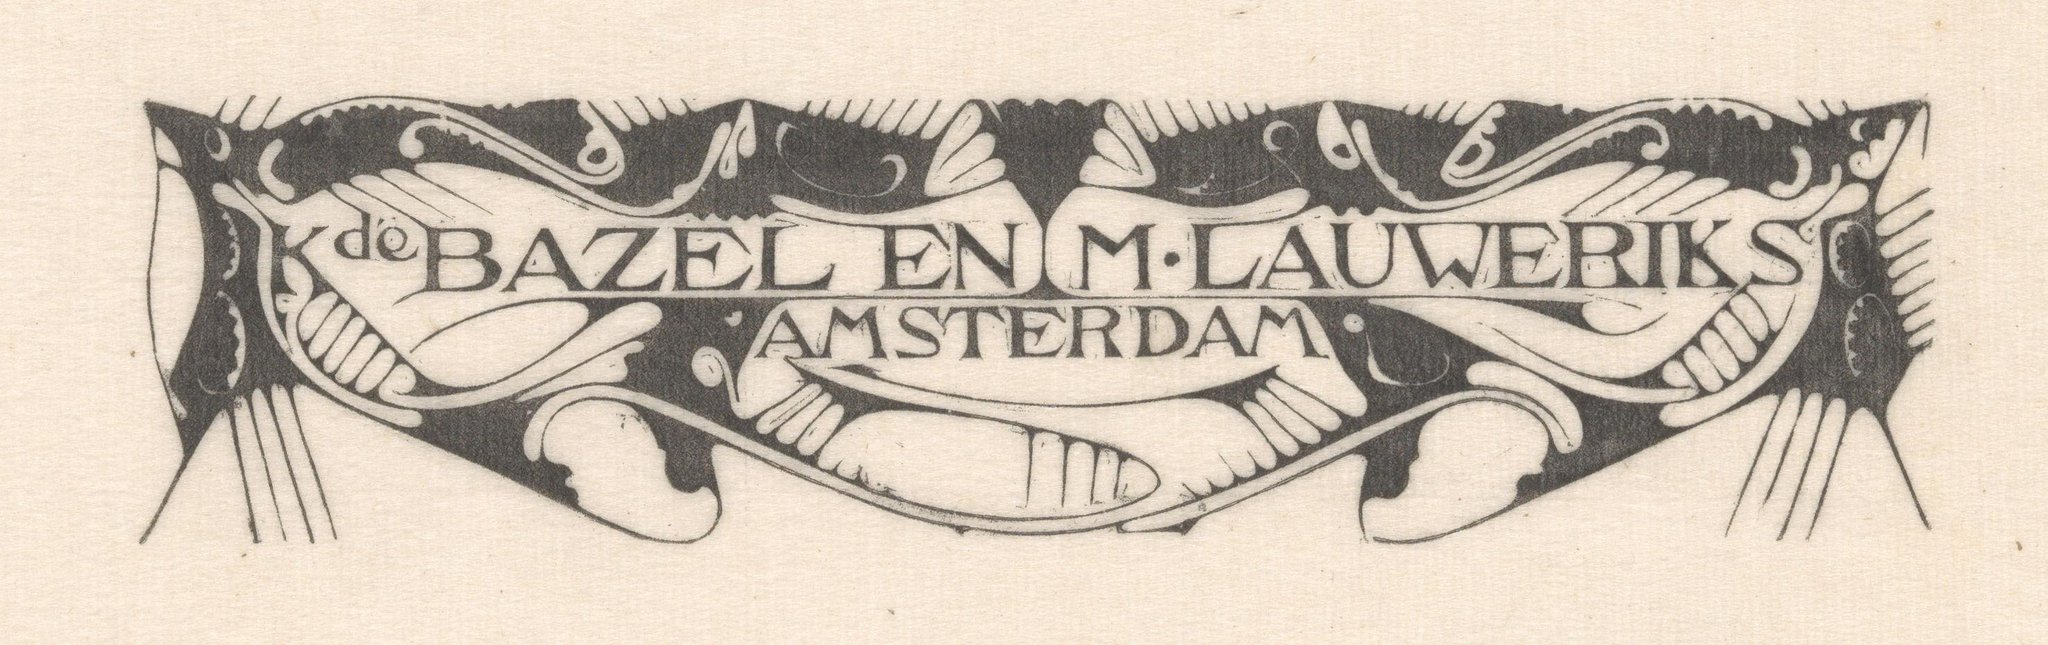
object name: print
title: Briefhoofd van Karel de Bazel en Mathieu Lauweriks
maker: karel petrus cornelis de bazel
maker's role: draughtsman, print maker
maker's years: 1869-1923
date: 1895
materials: paper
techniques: woodcut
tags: den helder, amsterdam, print maker, draughtsman, karel petrus cornelis de bazel, designer, mathieu lauweriks, letter, envelope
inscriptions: collector's mark: Lugt 2228